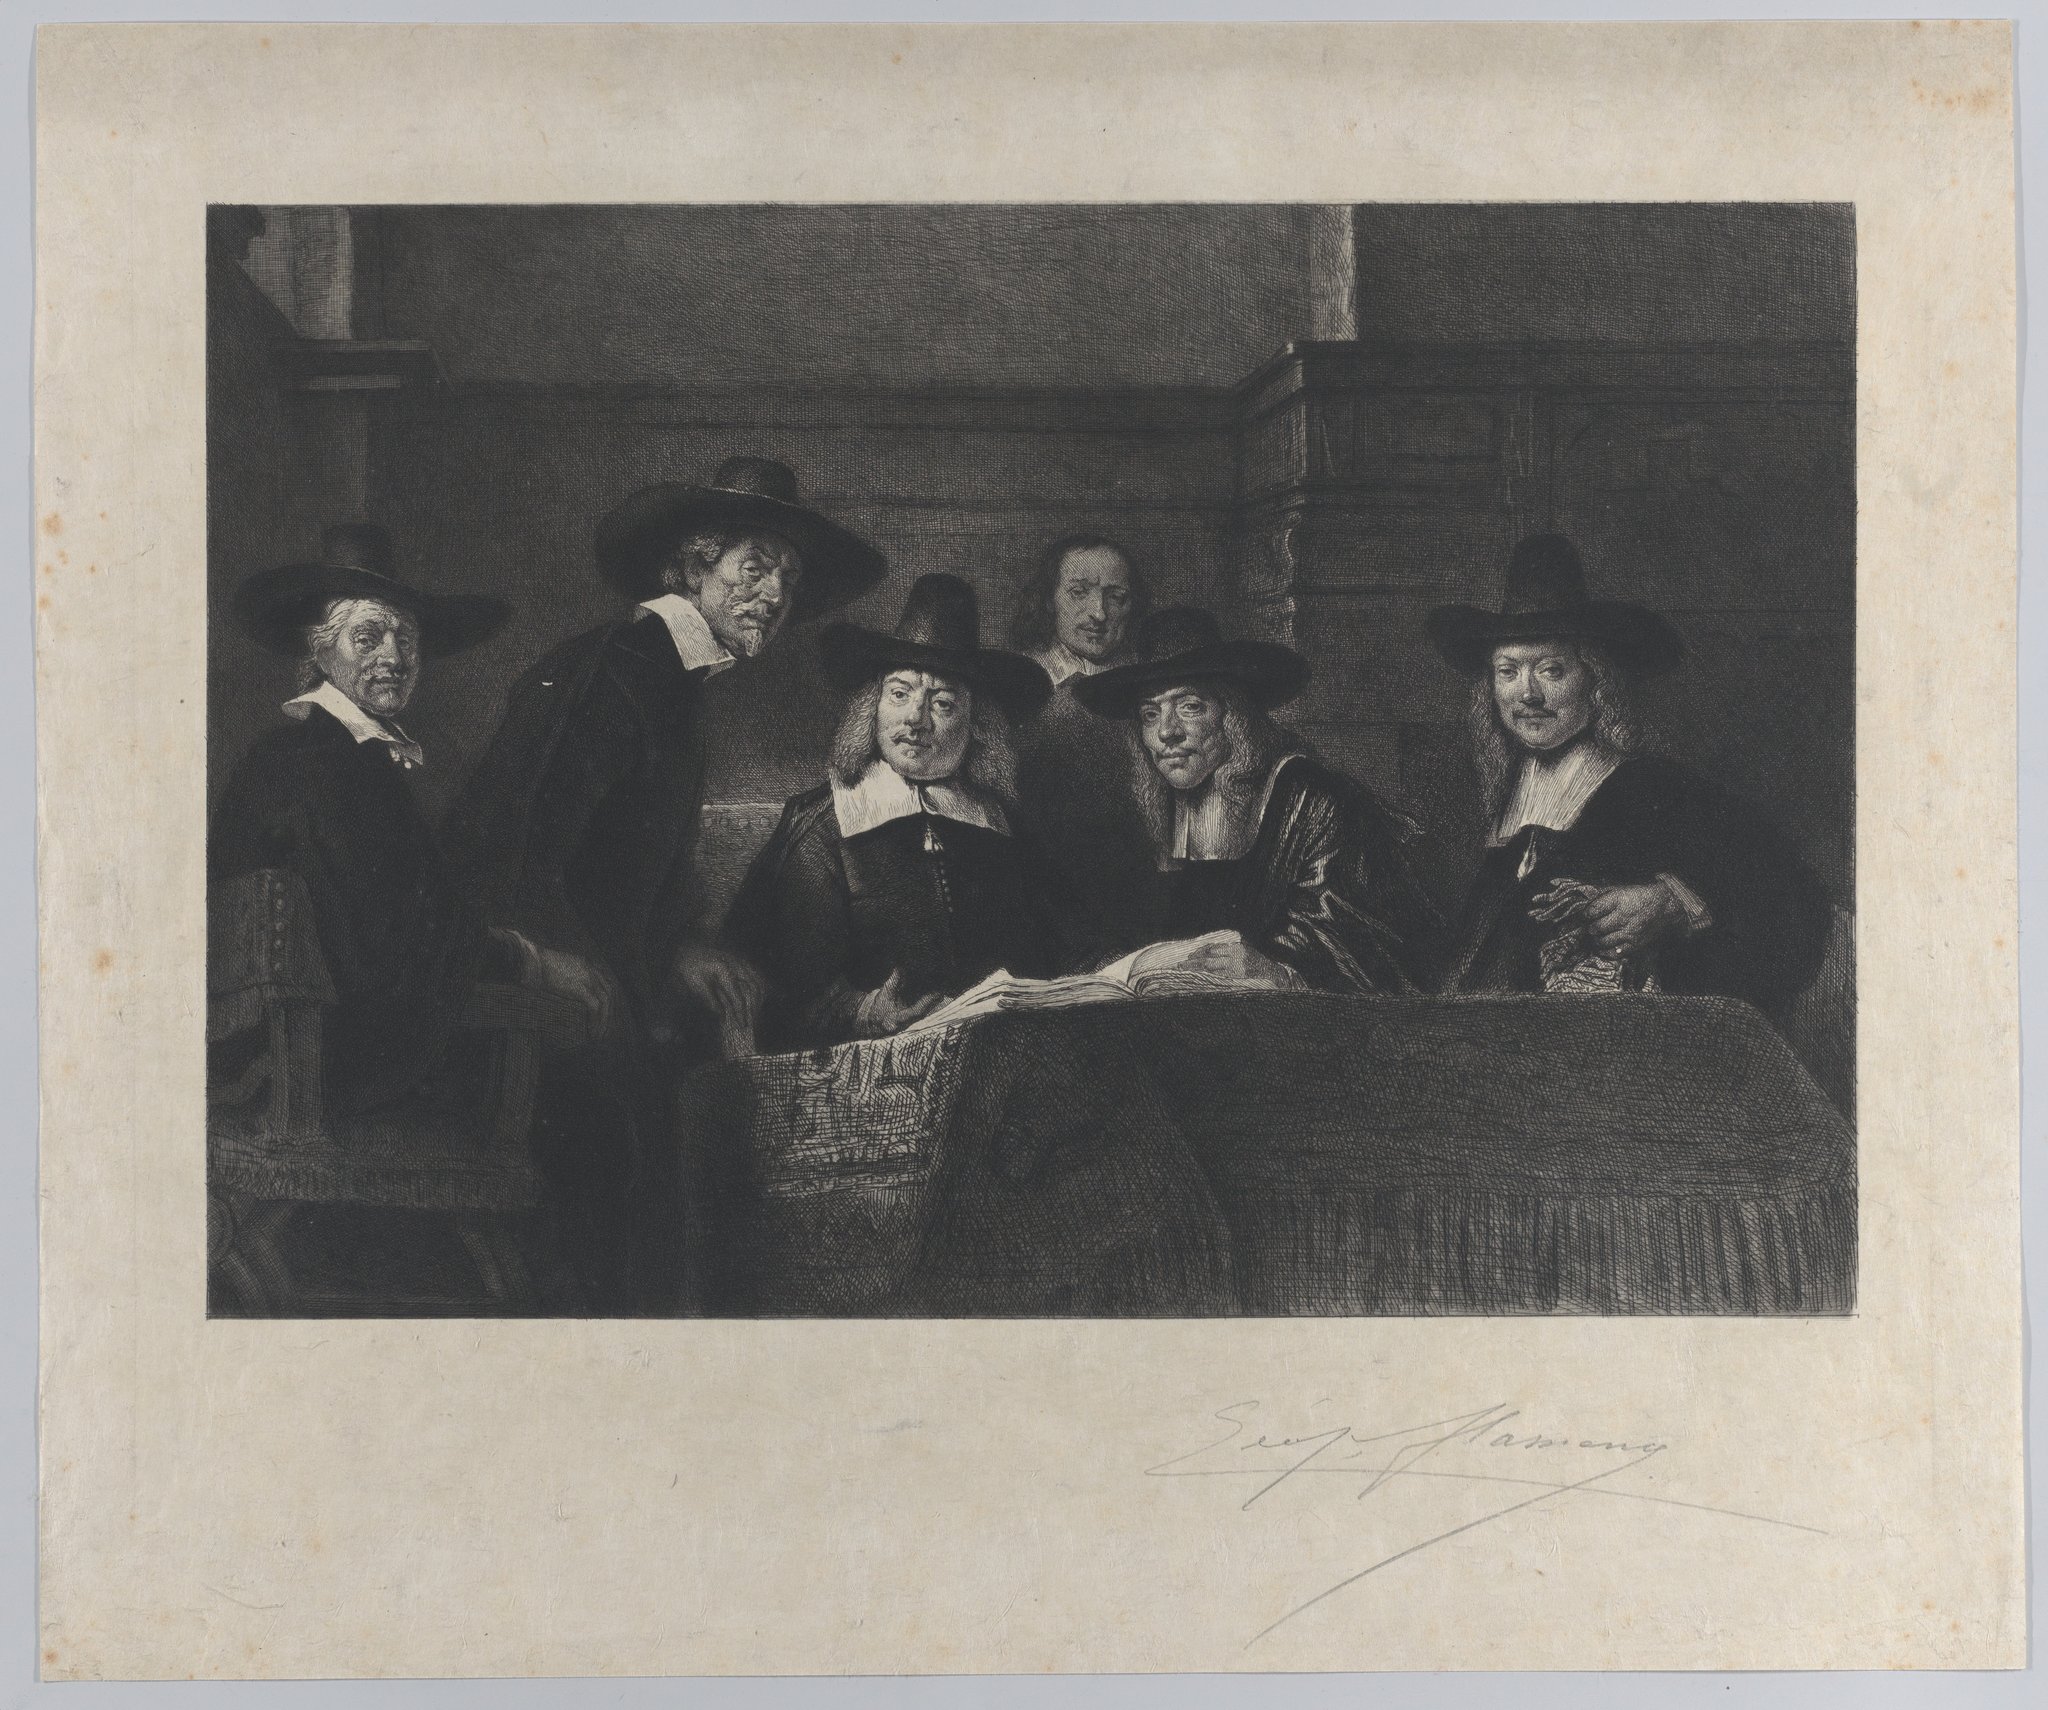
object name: print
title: The Syndics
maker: léopold flameng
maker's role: etcher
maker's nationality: french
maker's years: 1831-1911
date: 1876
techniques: etching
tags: men